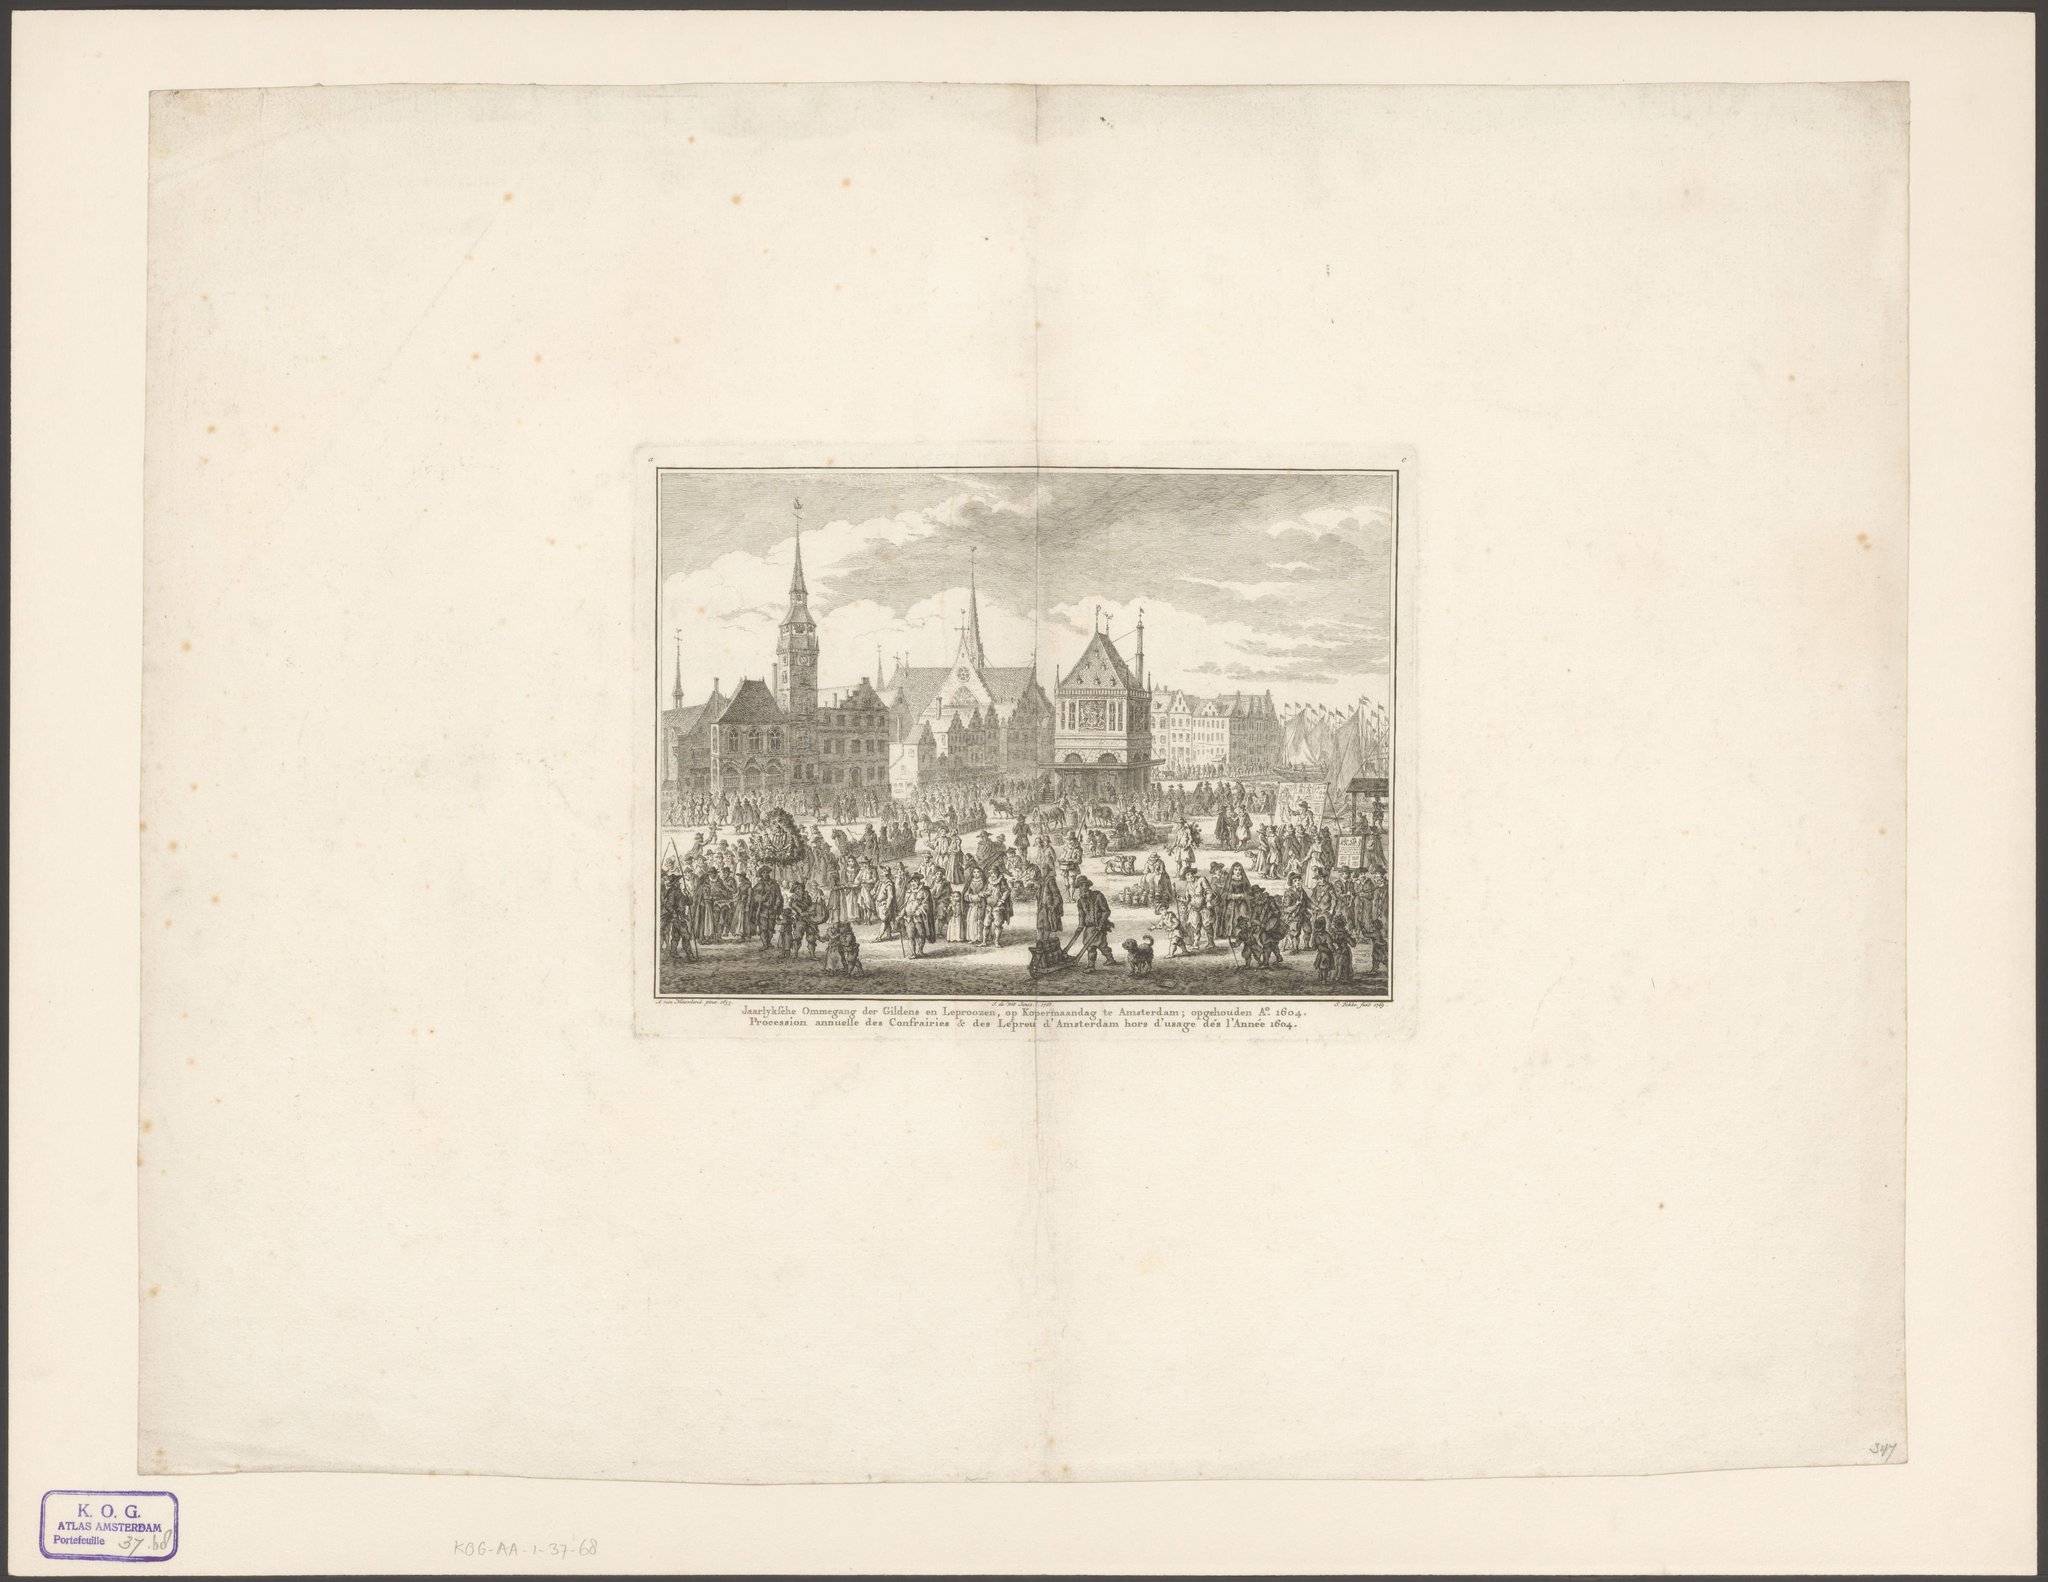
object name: print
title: Koppermaandag met leprozenoptocht te Amsterdam, 1604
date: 1769-1804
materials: paper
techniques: engraving, etching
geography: amsterdam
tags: 'blue monday', leper's procession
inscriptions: collector's mark: Lugt 1641b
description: Prent mogelijk uit: Atlas van de stad Amsterdam (...) / Atlas de la ville d'Amsterdam (...). Amsterdam: Reinier (II) Ottens, Pieter Yver, Johannes Smit, Frederik Willem Greebe, Albert van der Kroe en Jan Christiaan Sepp, 1769, dl. 3. Of uit: Elwe, Jan Barend. Atlas van de wereldberoemde koopstad Amsteldam (...). Amsterdam: Jan Barend Elwe, 1804.